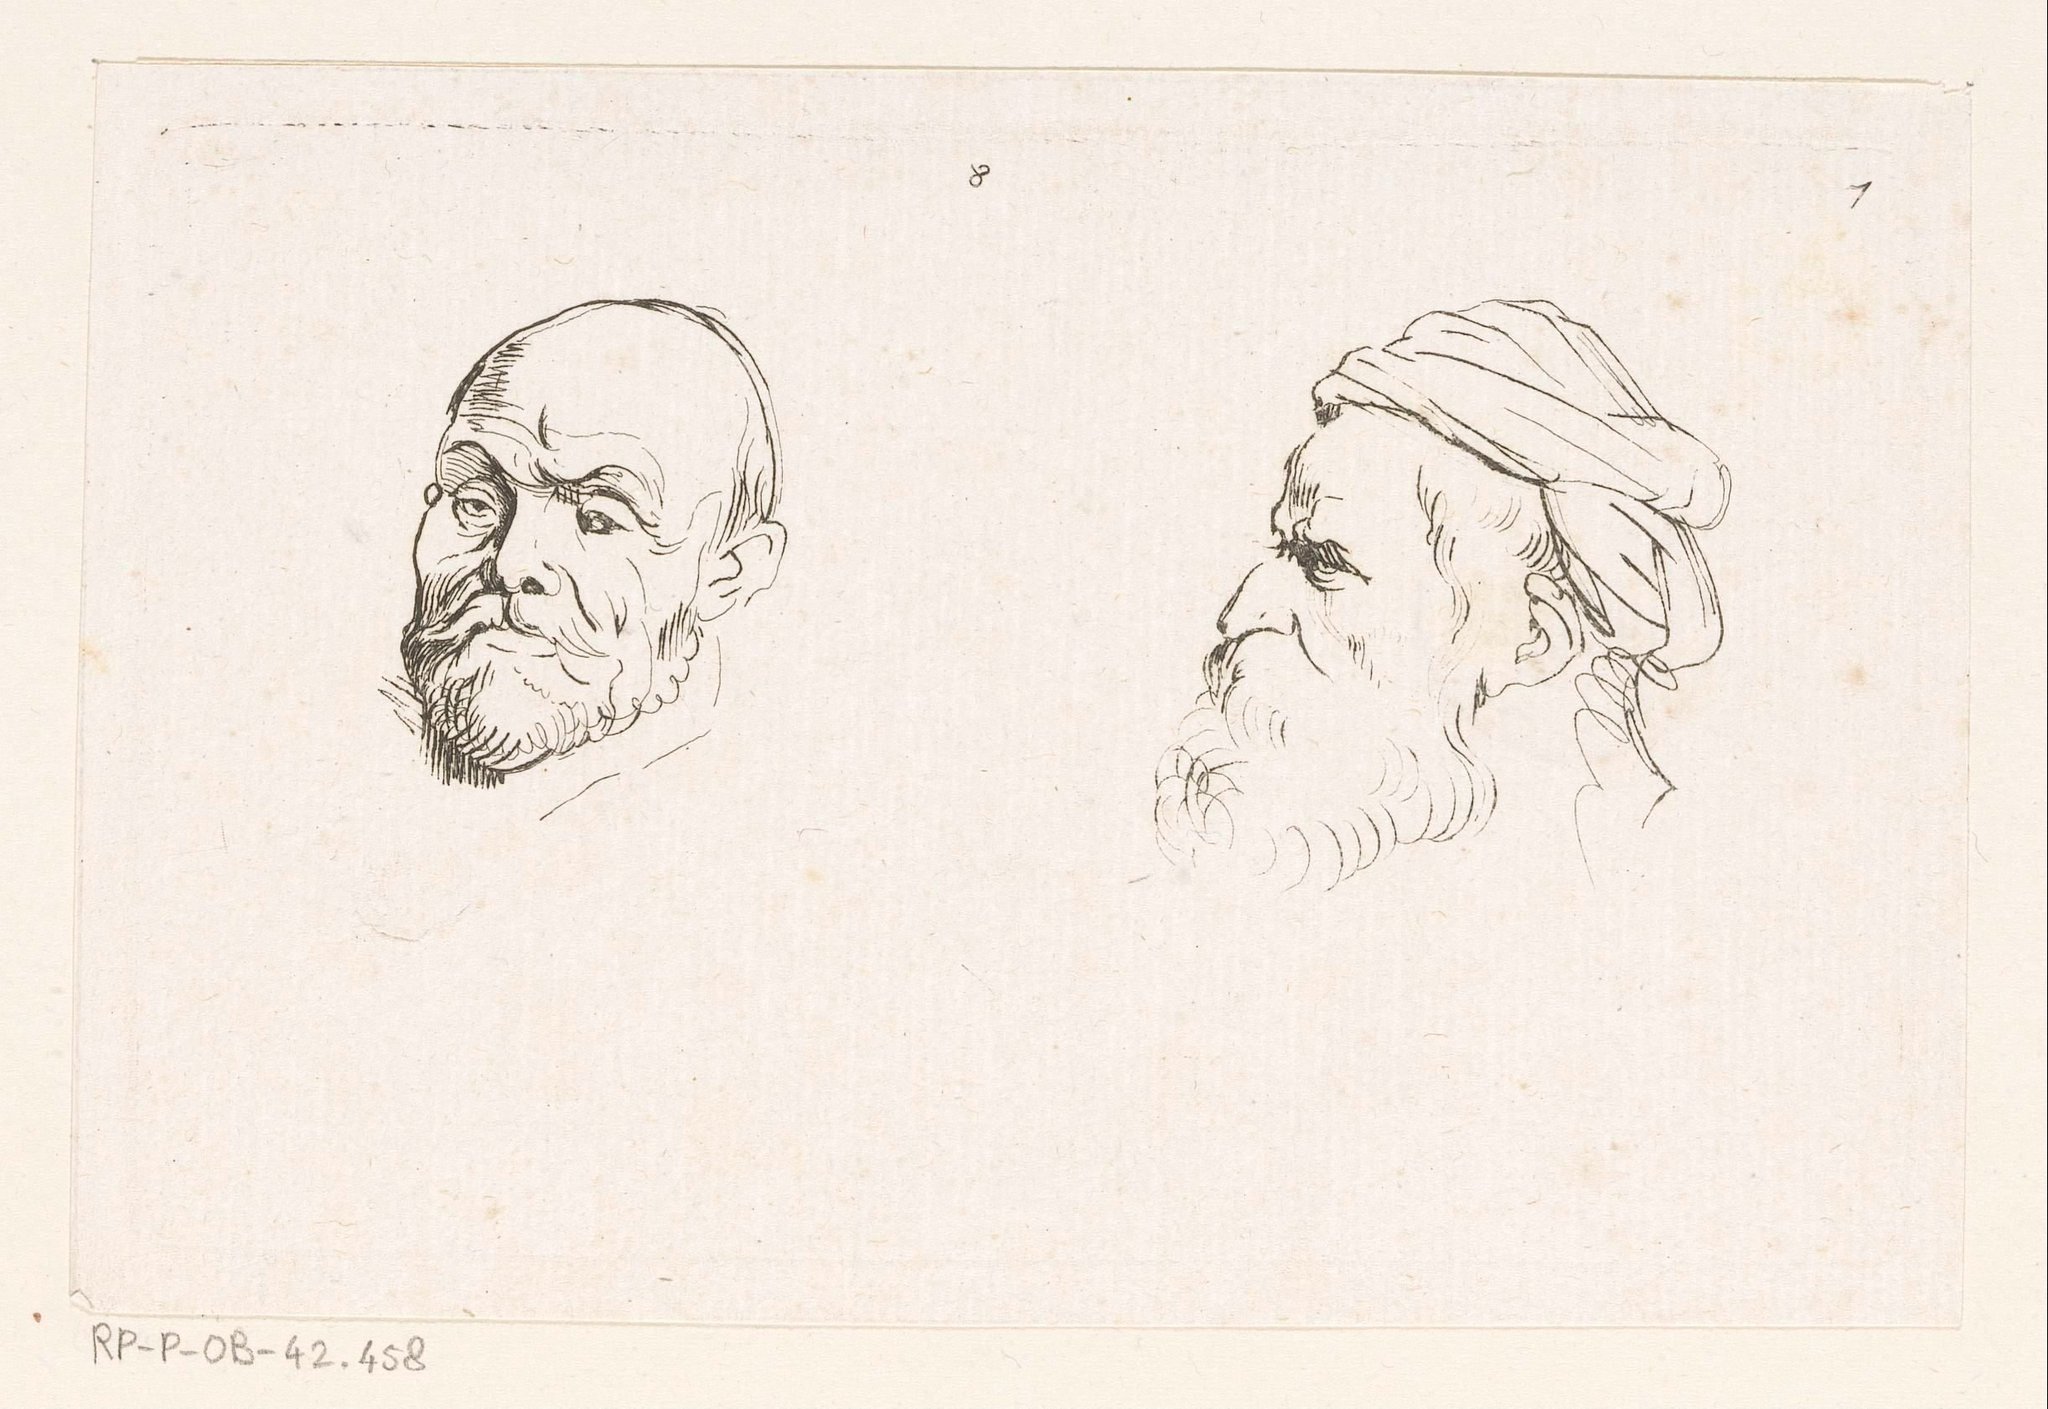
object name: print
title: Twee hoofden van mannen met baard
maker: anne claude philippe caylus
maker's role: print maker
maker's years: 1692-1765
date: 1735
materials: paper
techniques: etching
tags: head (human), head-gear, old man, beard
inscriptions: collector's mark: Lugt 240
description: Prent uit een serie van 31 prenten naar getekende hoofden door Van Dyck, plus een titelprent naar Bouchardon, getiteld: "Recueil de Testes d'Antoine Van Dyck tirées du Cabinet de M. Crozat et gravées par M. le C. de C.".